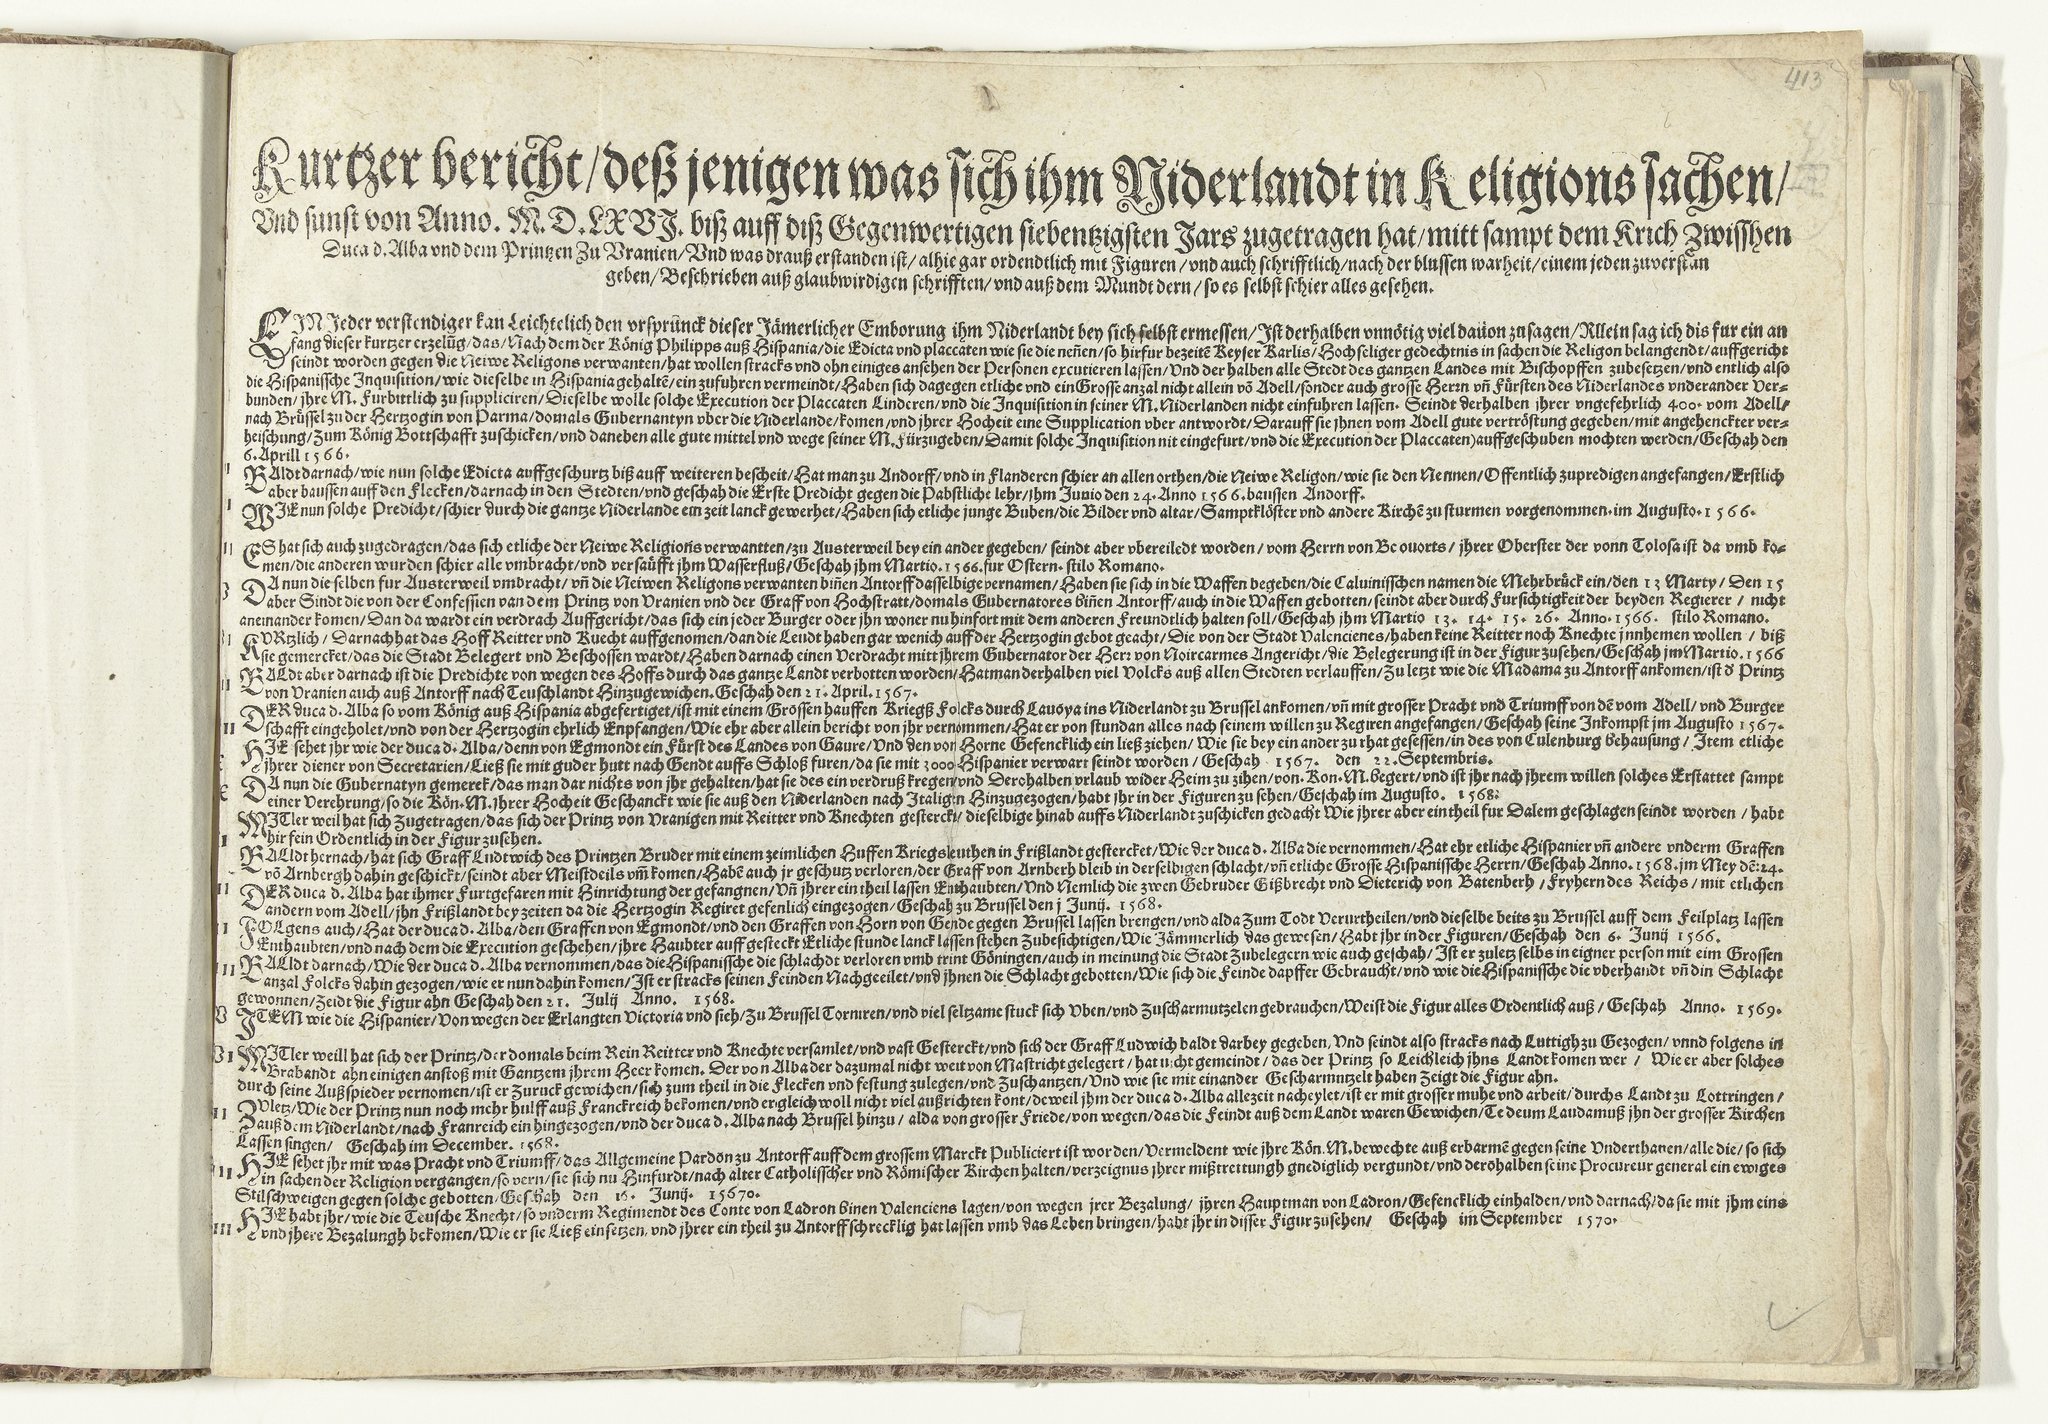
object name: titelblad, titelpagina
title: Serie 5: Nederlandse Gebeurtenissen, 1566-1570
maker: frans hogenberg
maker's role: print maker, publisher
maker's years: 1538-1590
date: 1570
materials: paper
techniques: letterpress printing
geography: cologne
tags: tachtigjarige oorlog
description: Titelpagina met een overzicht van de 19 prenten genummerd I-XVIIII die in dit deel voorkomen, met voorstellingen van de gebeurtenissen in de Nederlanden in de jaren 1566-1570. Tekst in het Duits.